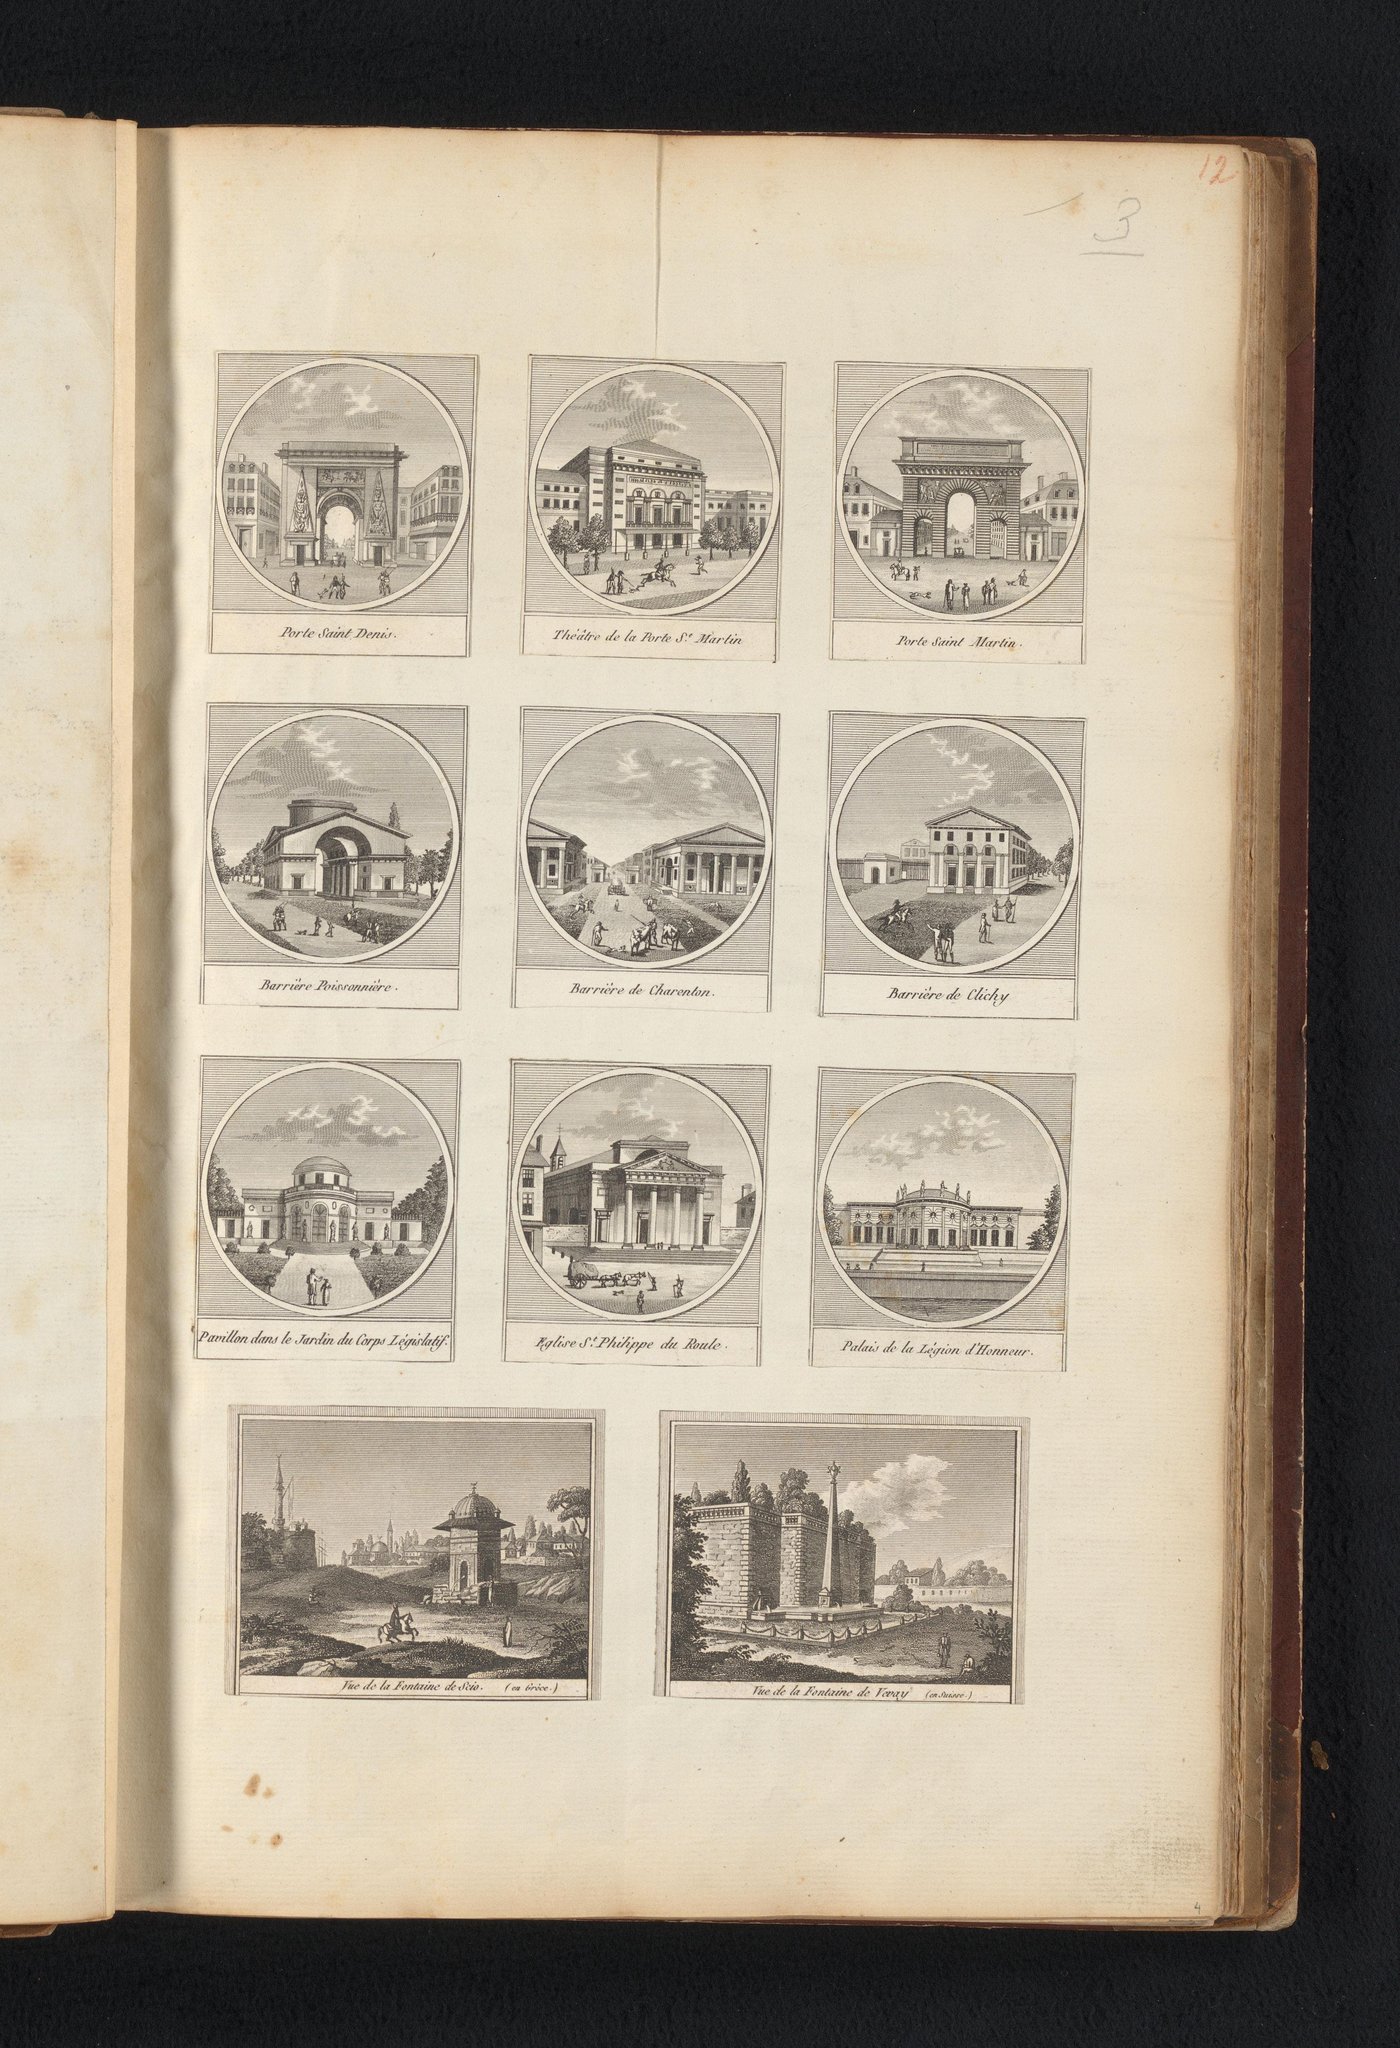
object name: print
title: Parijse monumenten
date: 1750-1816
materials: paper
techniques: engraving, etching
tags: church (exterior), landscape with ruins, city-gate, paris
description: Negen ronde voorstellingen van gebouwen in Parijs, en twee met ruïnes. Onderdeel van het tweede van twee albums met ingeplakte prenten en tekeningen te dienen als tekenvoorbeelden.